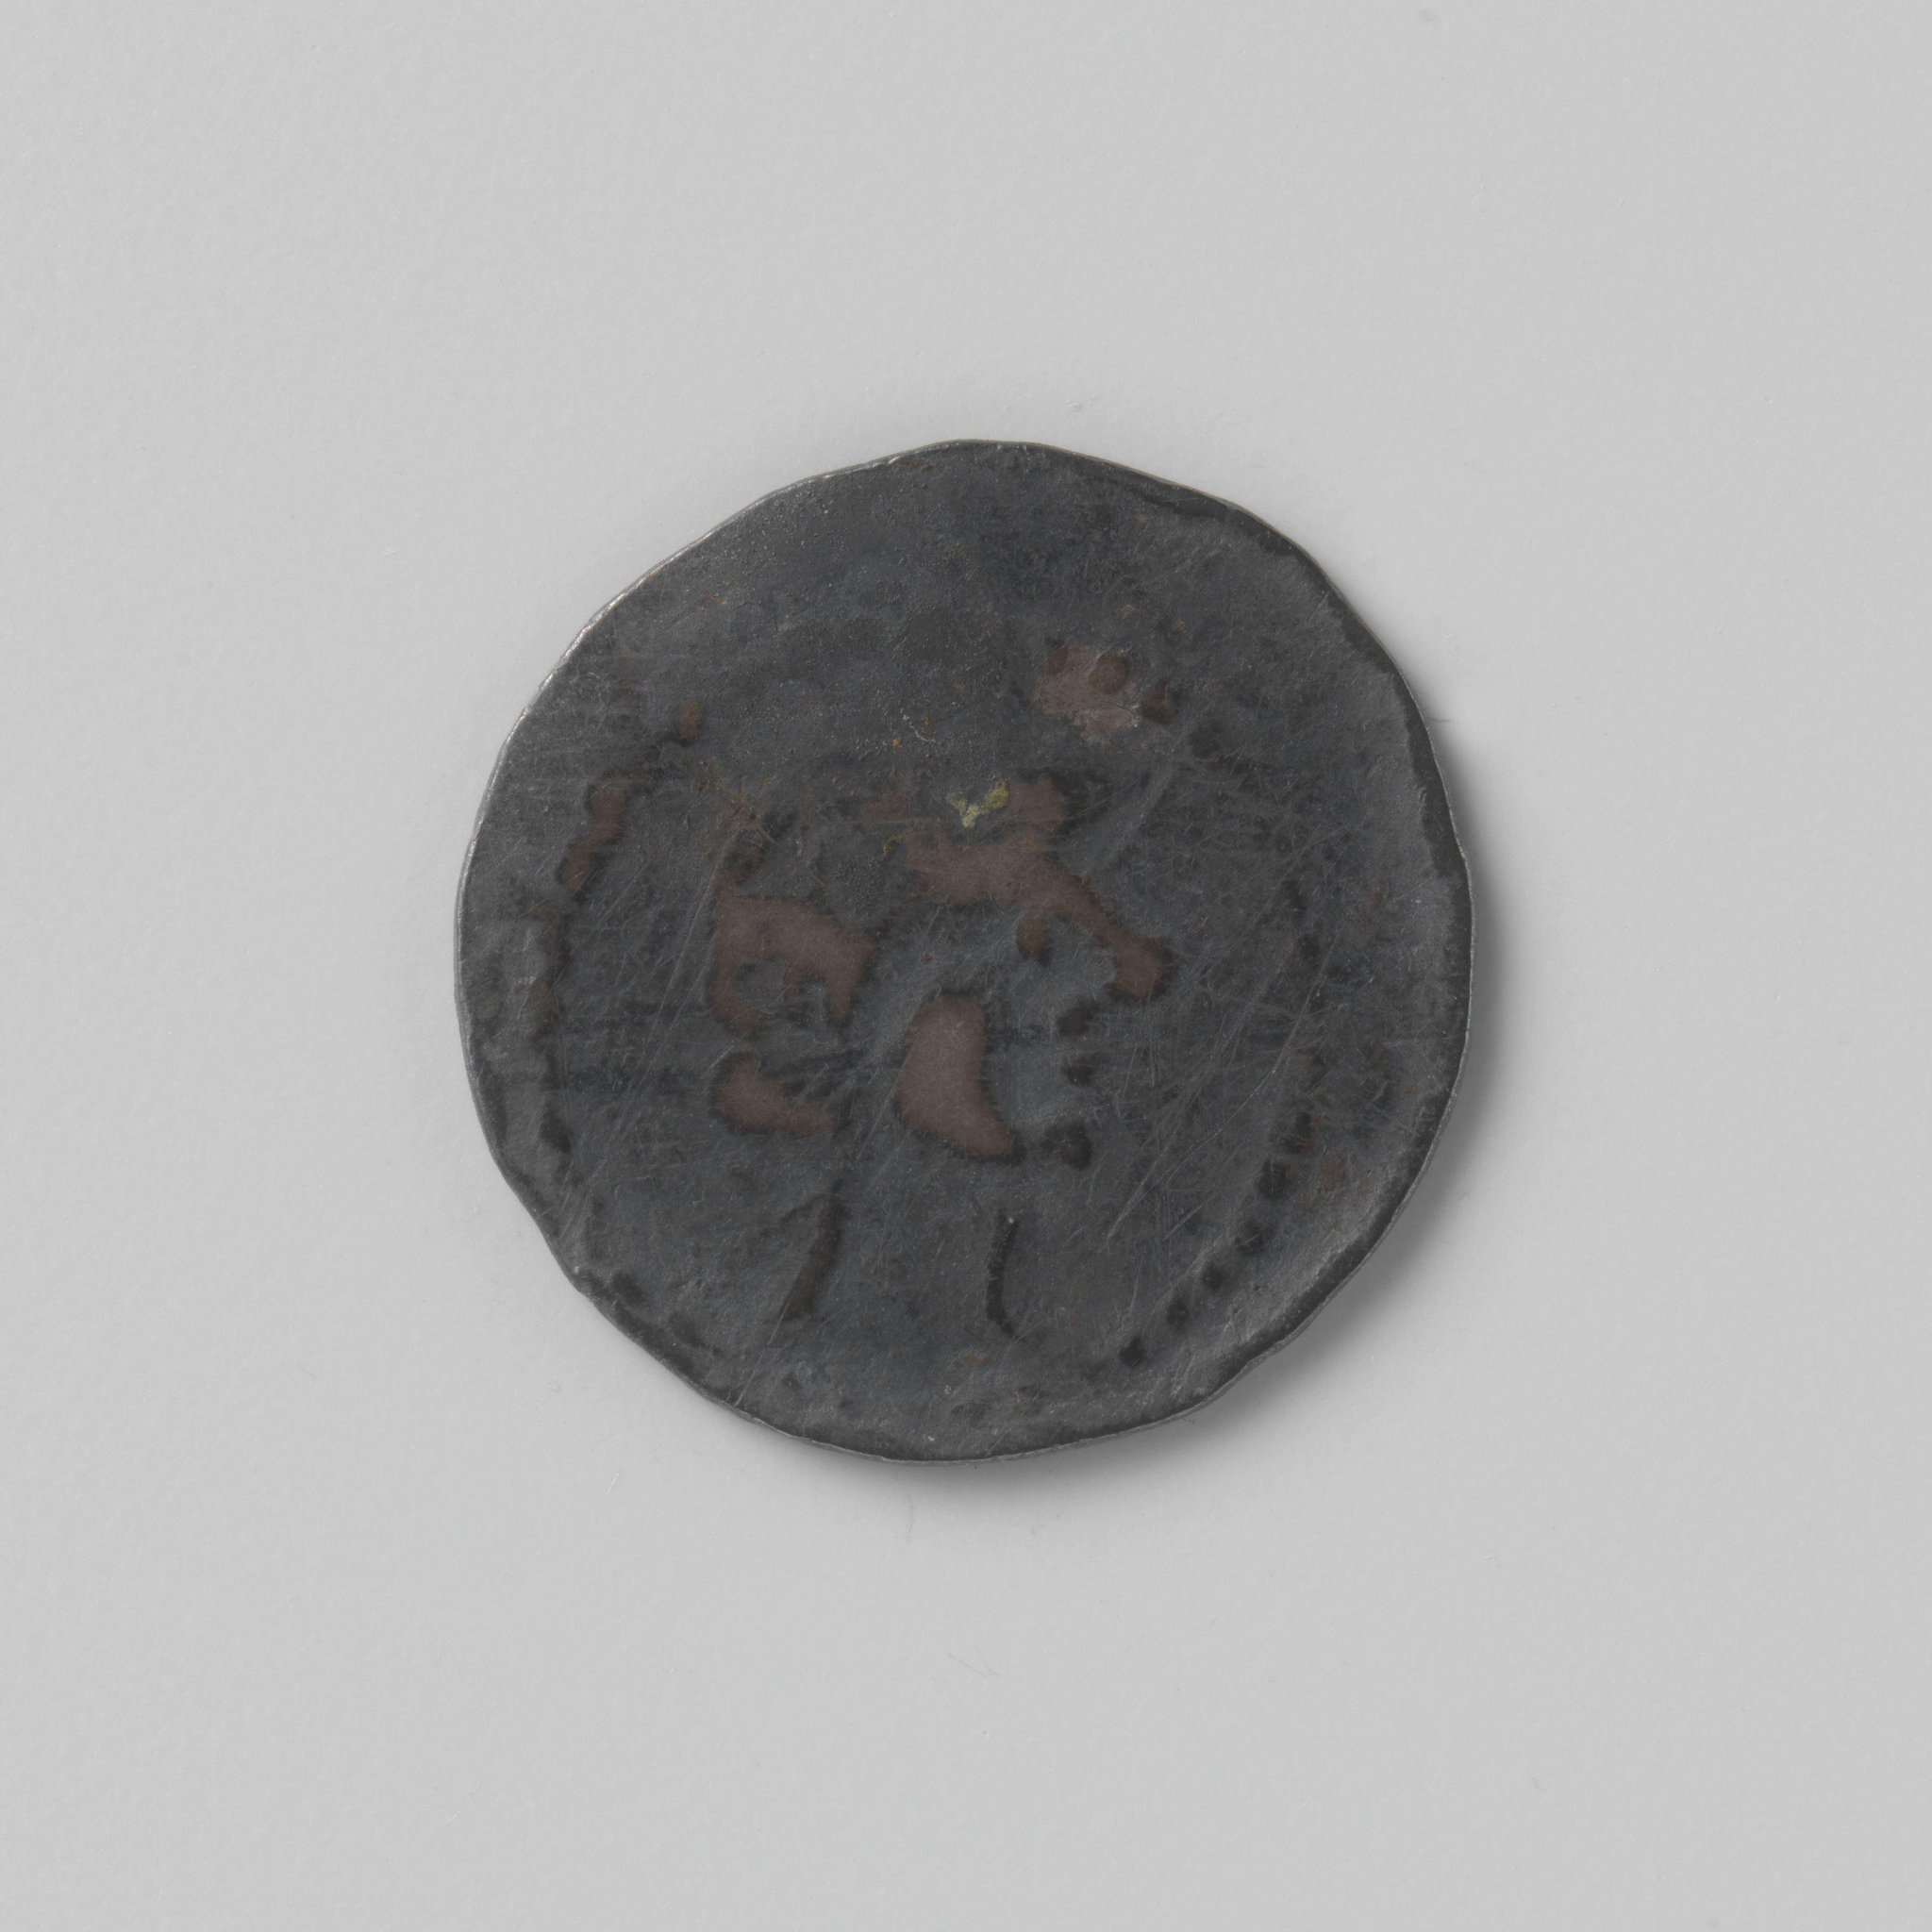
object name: penny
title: Hollandse penning van Floris V, 1256-1296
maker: floris v (graaf van holland en zeeland)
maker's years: 1254-1296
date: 1275-1284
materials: silver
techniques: striking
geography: dordrecht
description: Zilveren munt. Voorzijde: hoofd met gravenmuts naar rechts. Keerzijde: lang dubbellijnig kruis.